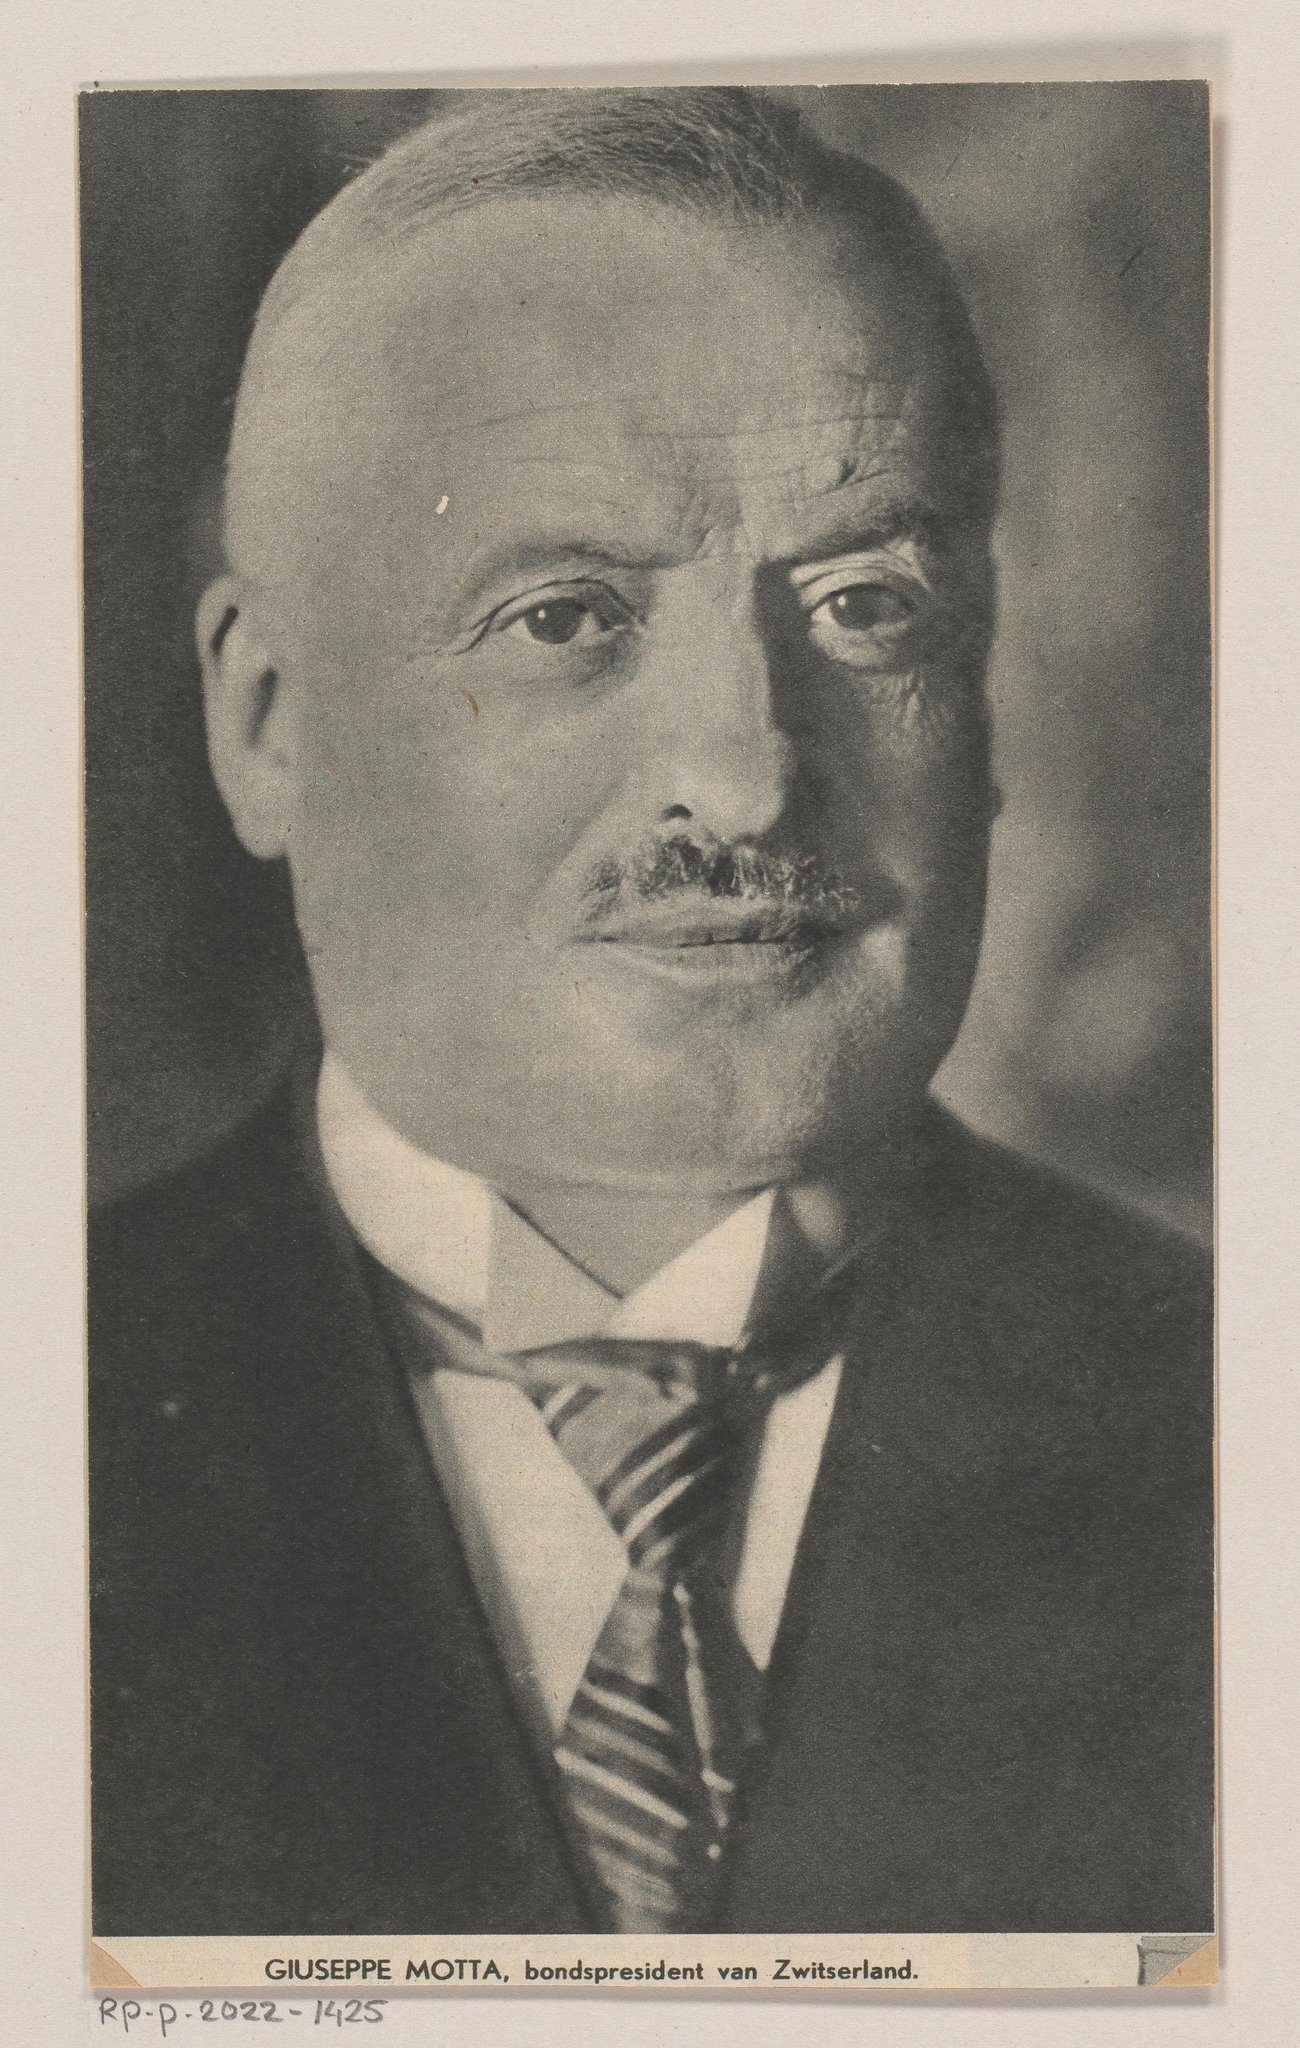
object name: photomechanical print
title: Giuseppe Motta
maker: Anonymous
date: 1915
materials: paper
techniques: letterpress printing, photoaquatint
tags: historical persons, politician, e.g. party leader